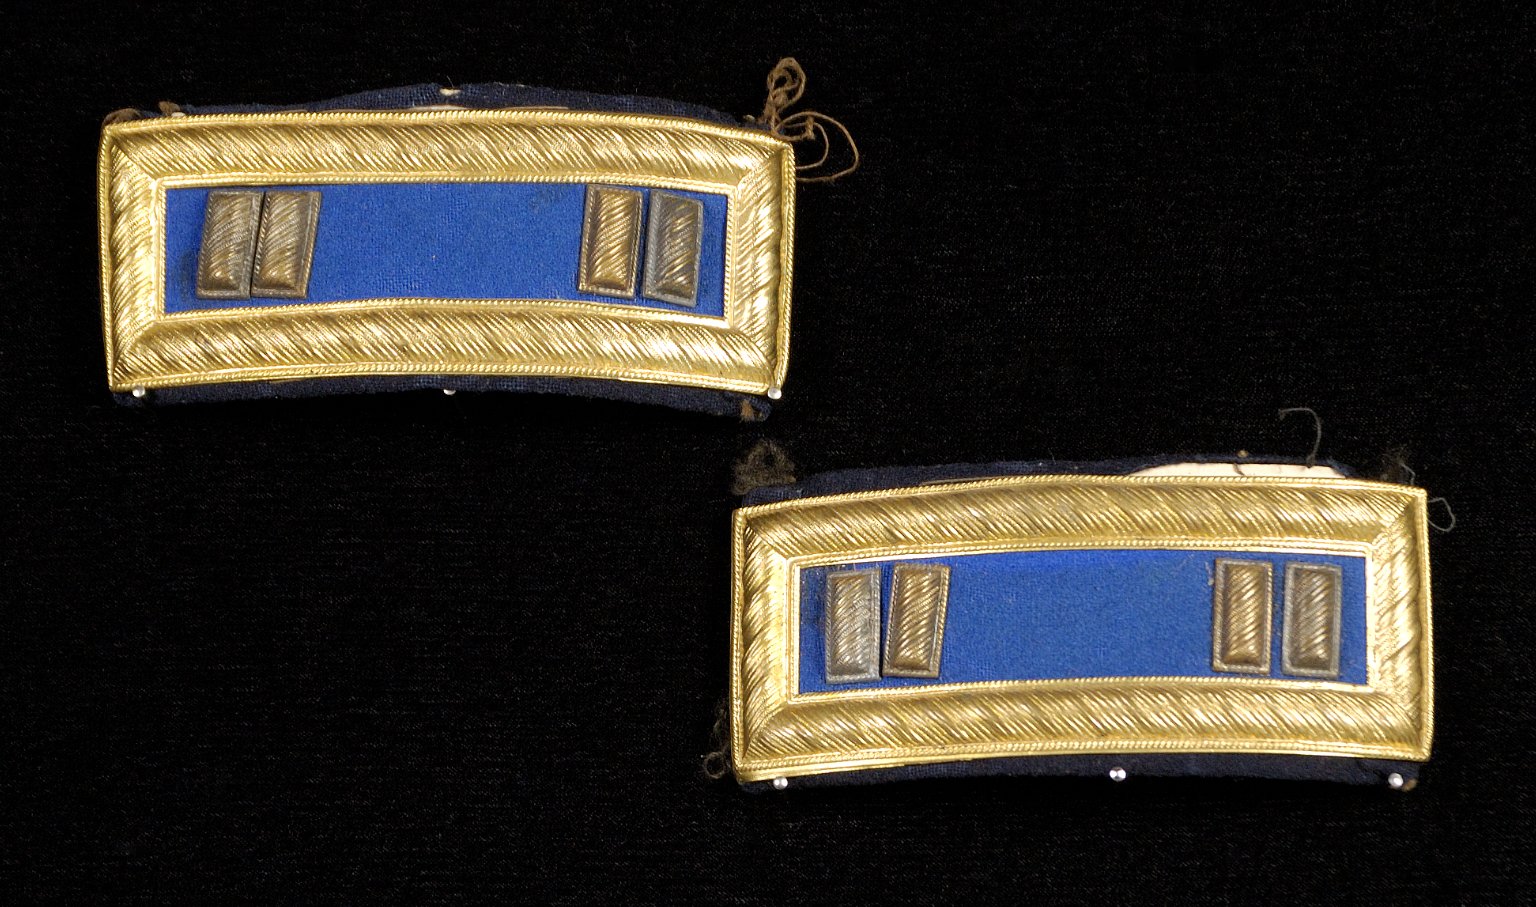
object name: military epaulet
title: Military epaulets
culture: american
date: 1875-1880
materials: metal, wool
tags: army